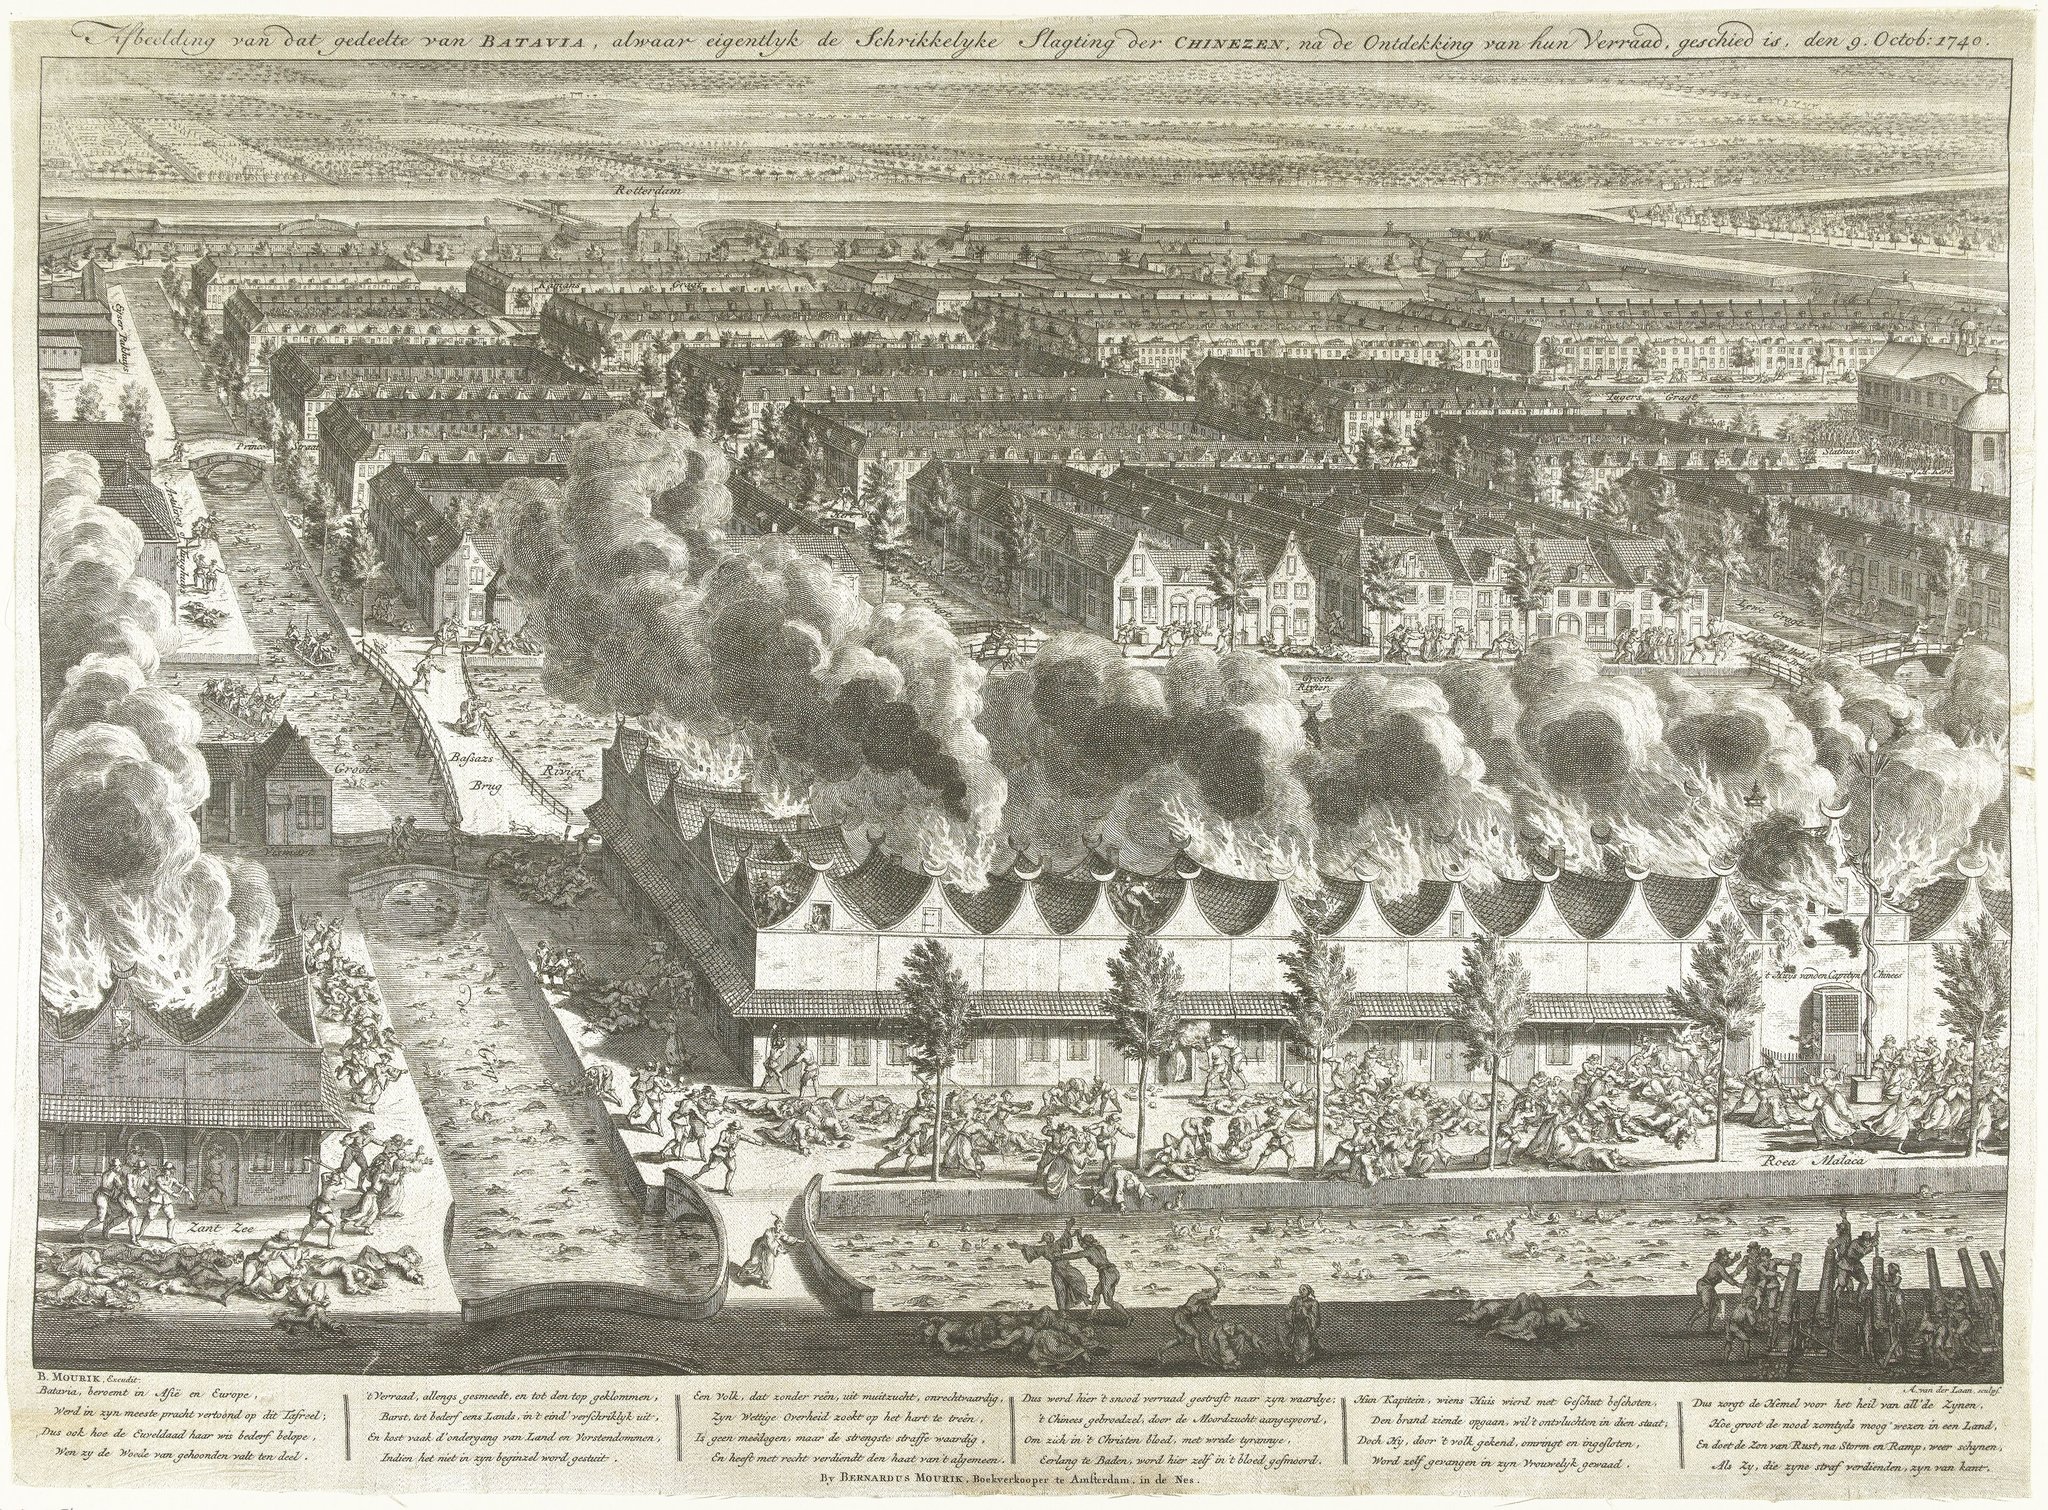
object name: print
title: Moord op Chinezen te Batavia, 1740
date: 1740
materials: textile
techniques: engraving, etching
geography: amsterdam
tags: massacre ~ war, batavia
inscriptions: collector's mark: Lugt 2228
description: De massamoord op de Chinezen door de Nederlanders in de Chinese wijk van Batavia, na de ontdekking van het vermeende verraad, 9 oktober 1740. De straten en grachten liggen vol met de lichamen van vermoorde Chinezen. Op de voorgrond staat het Chinese huizenblok in brand, rechts de beschieting met kanonnen van het huis van de Chinese kapitein aan de gracht Roea Malaca gemarkeerd door de paal met de slang; de kapitein die in vrouwenkleren probeert te vluchten wordt gevangengenomen. Met onderschrift een vers in zes kolommen.